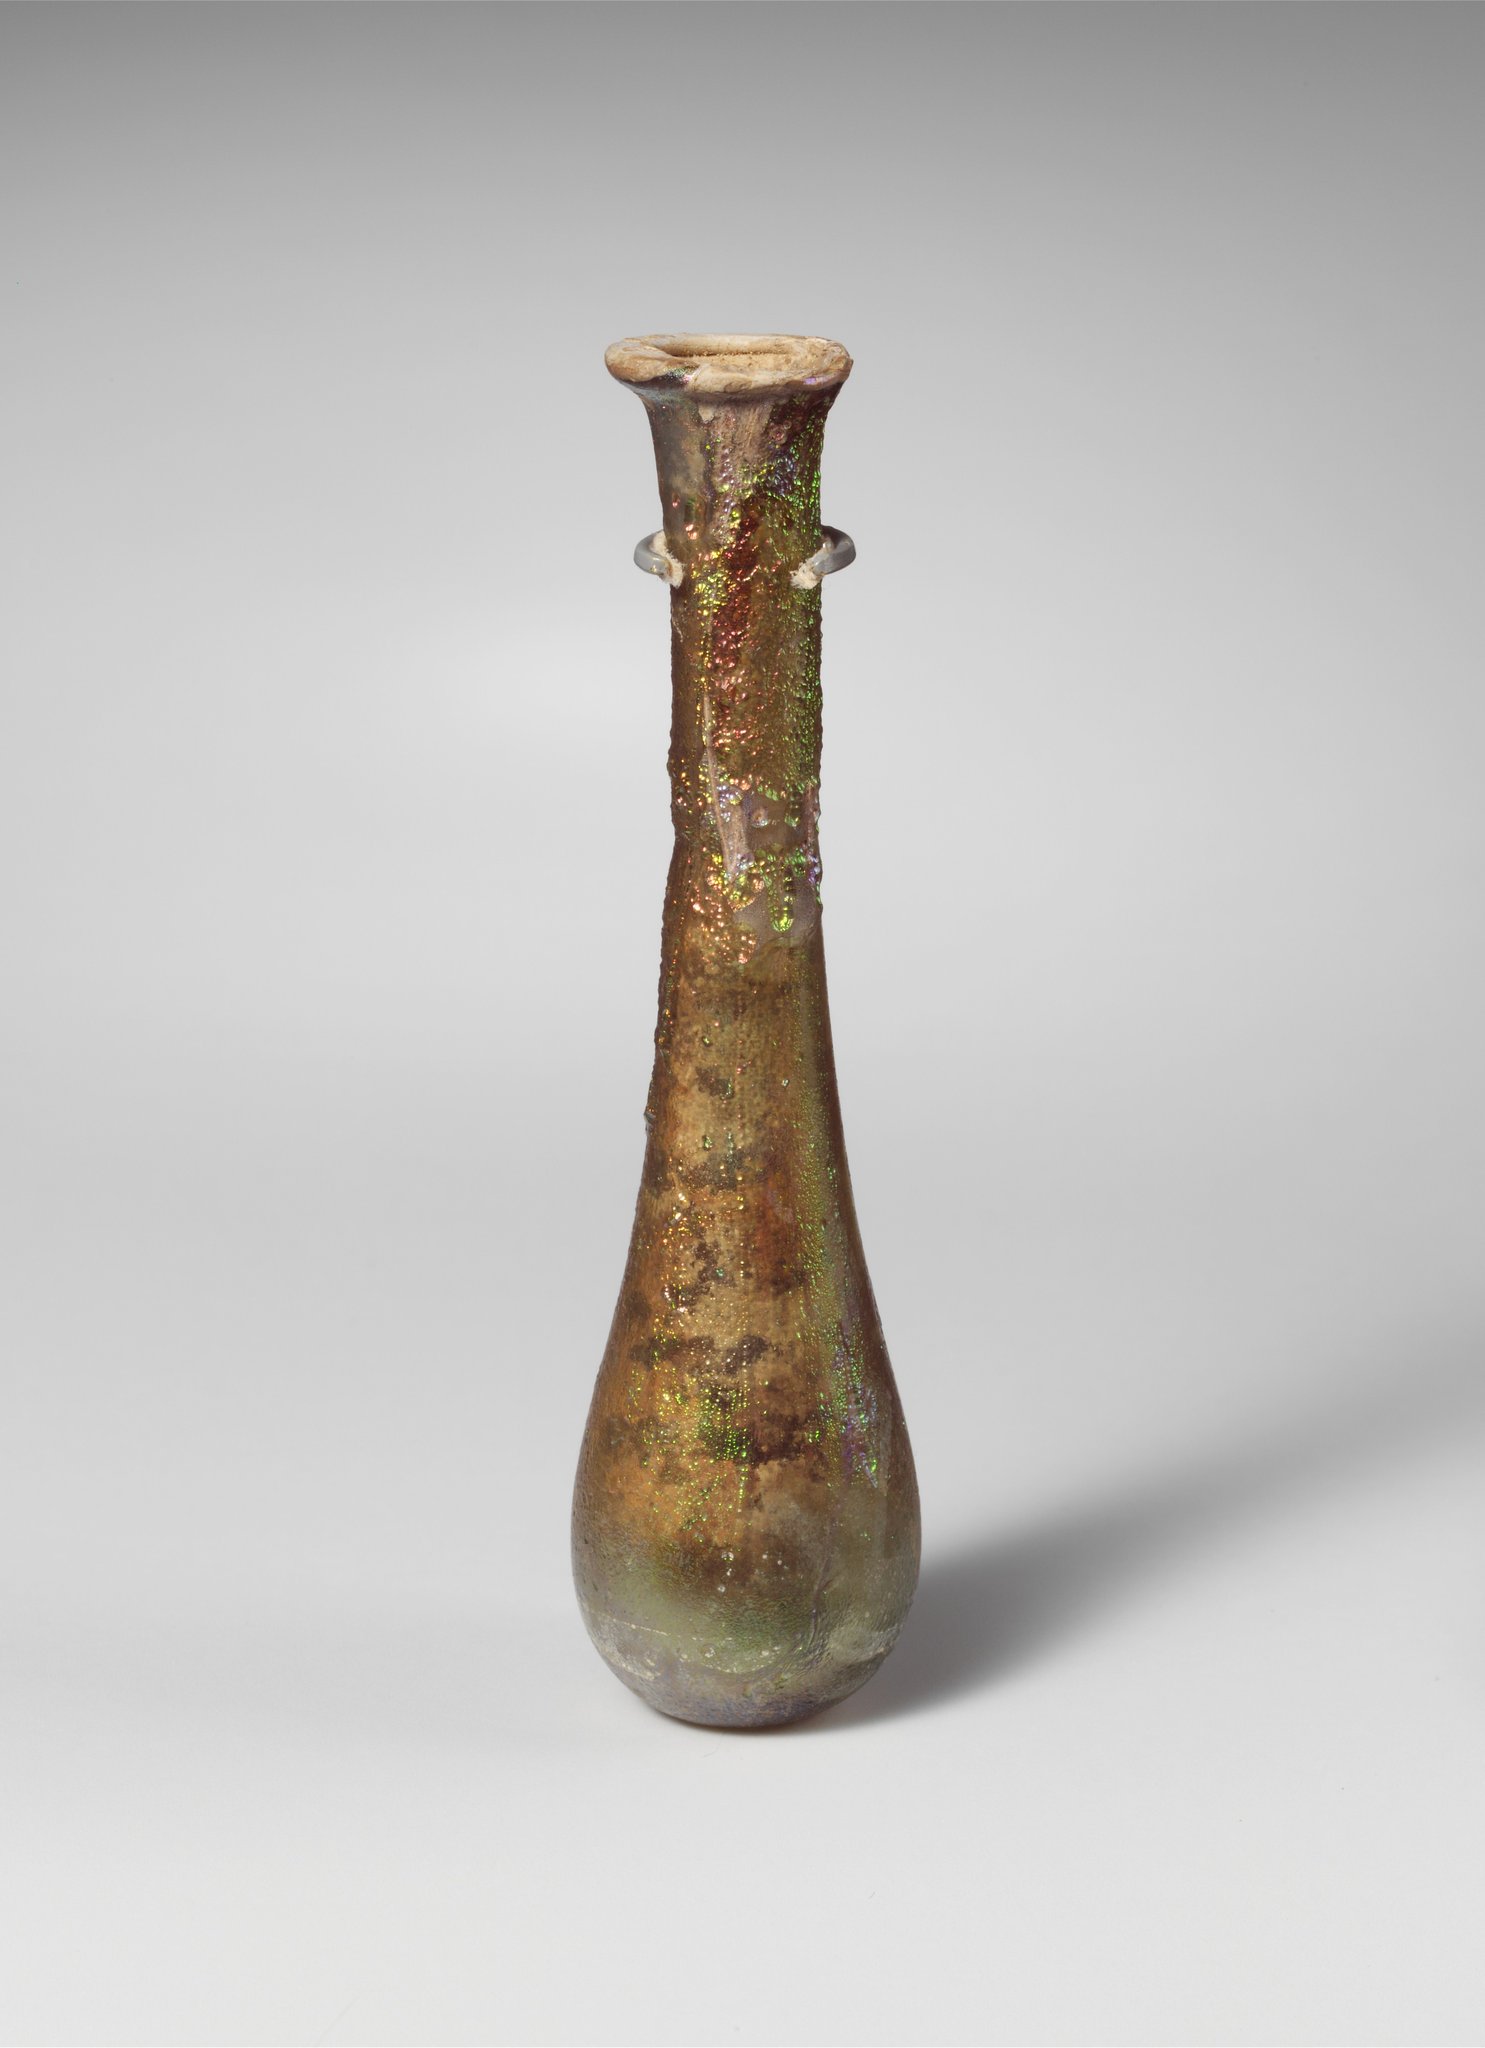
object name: perfume bottle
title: Glass perfume bottle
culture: roman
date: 1-200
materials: glass